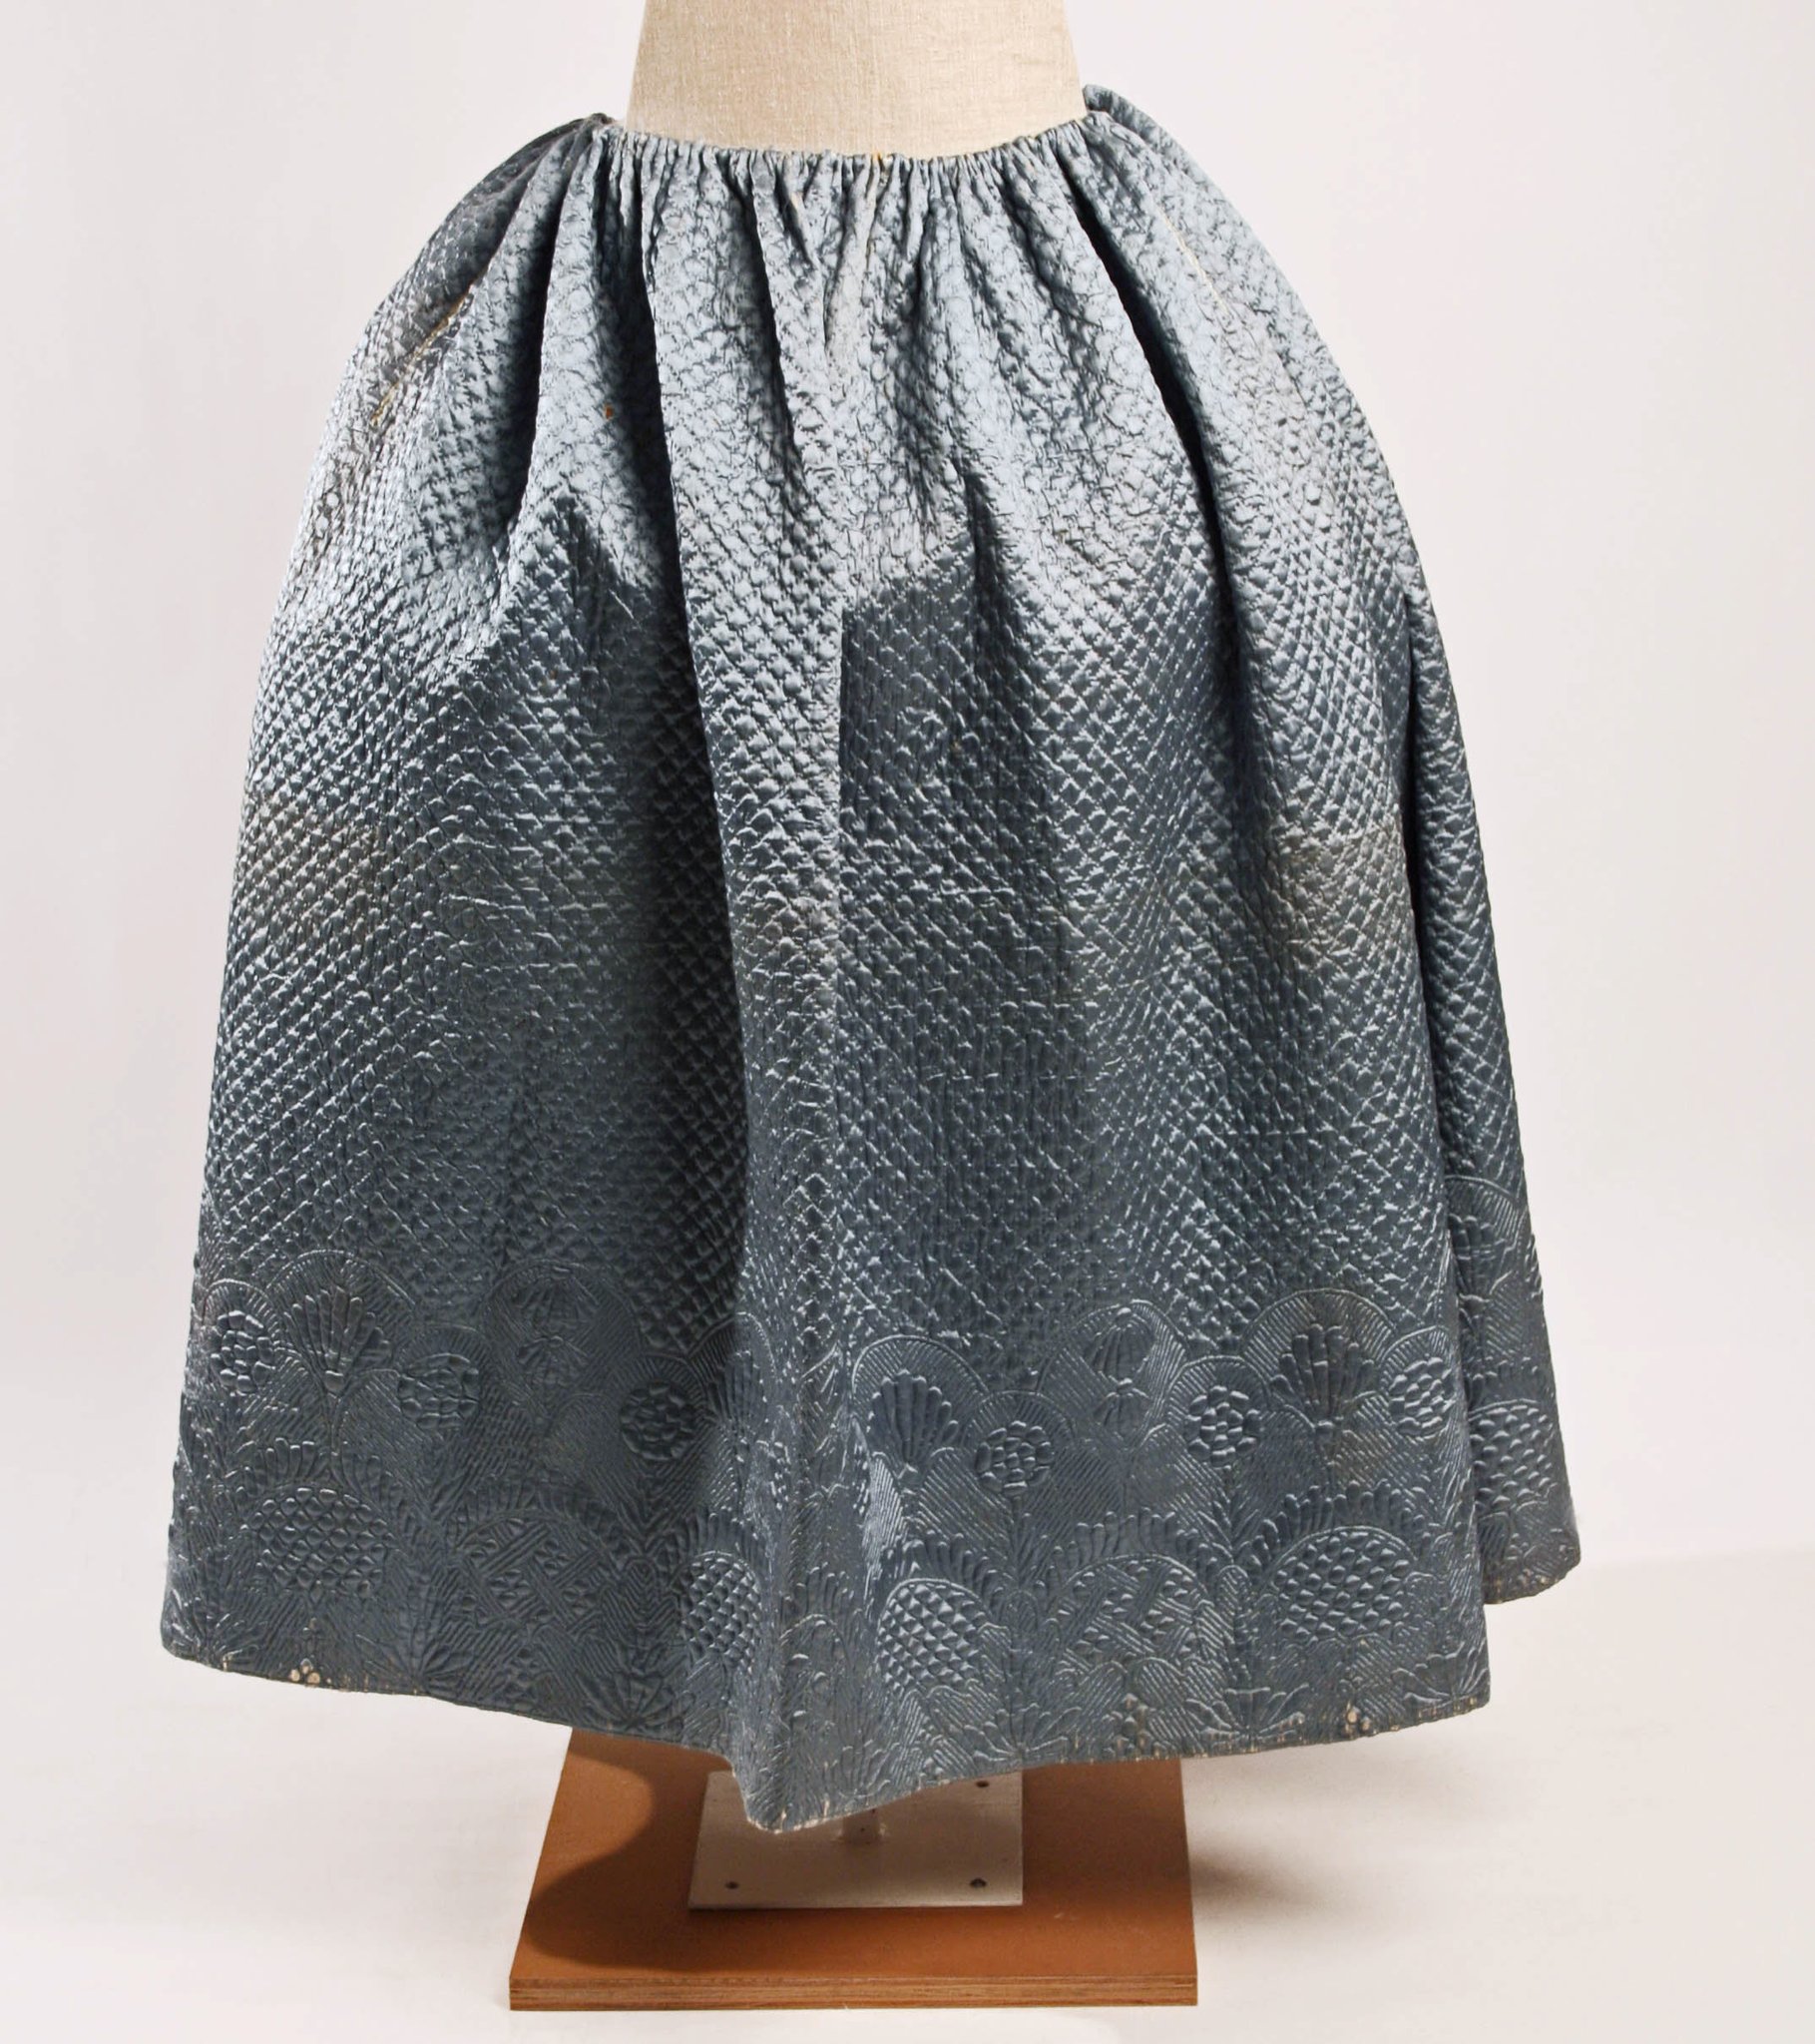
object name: petticoat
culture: french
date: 1701-1800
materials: cotton, silk